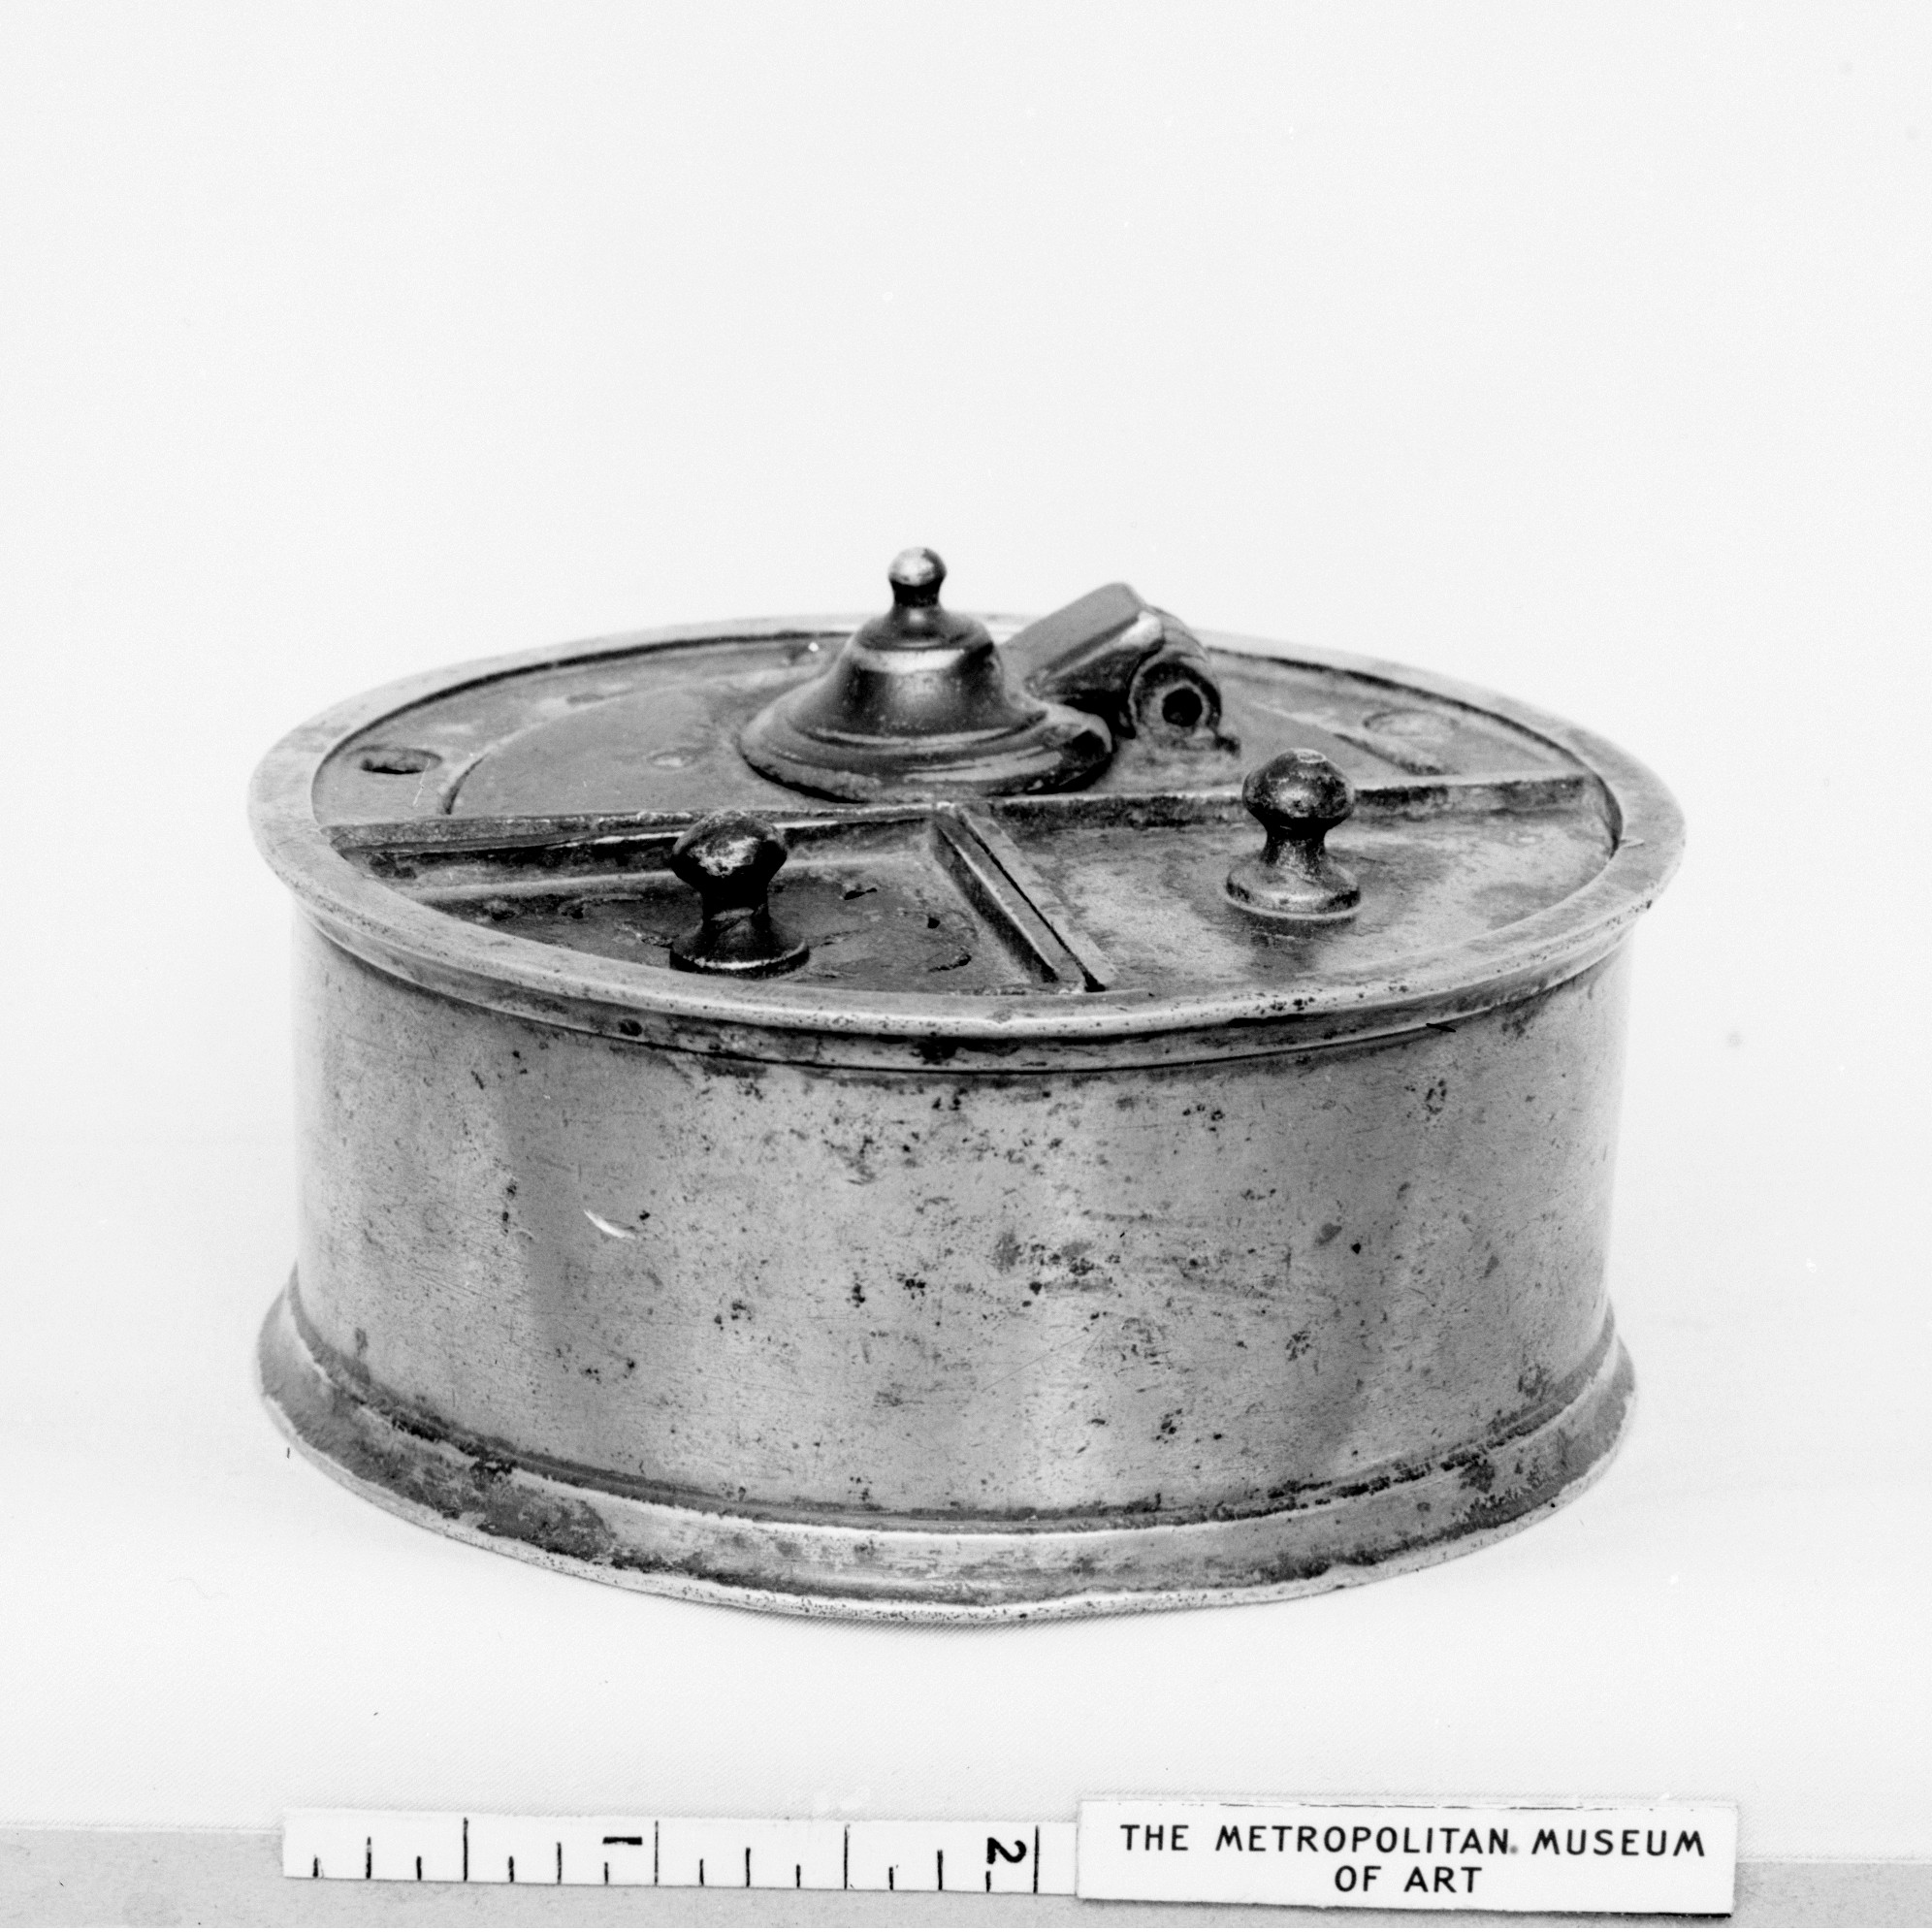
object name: inkstand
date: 1751-1800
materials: pewter